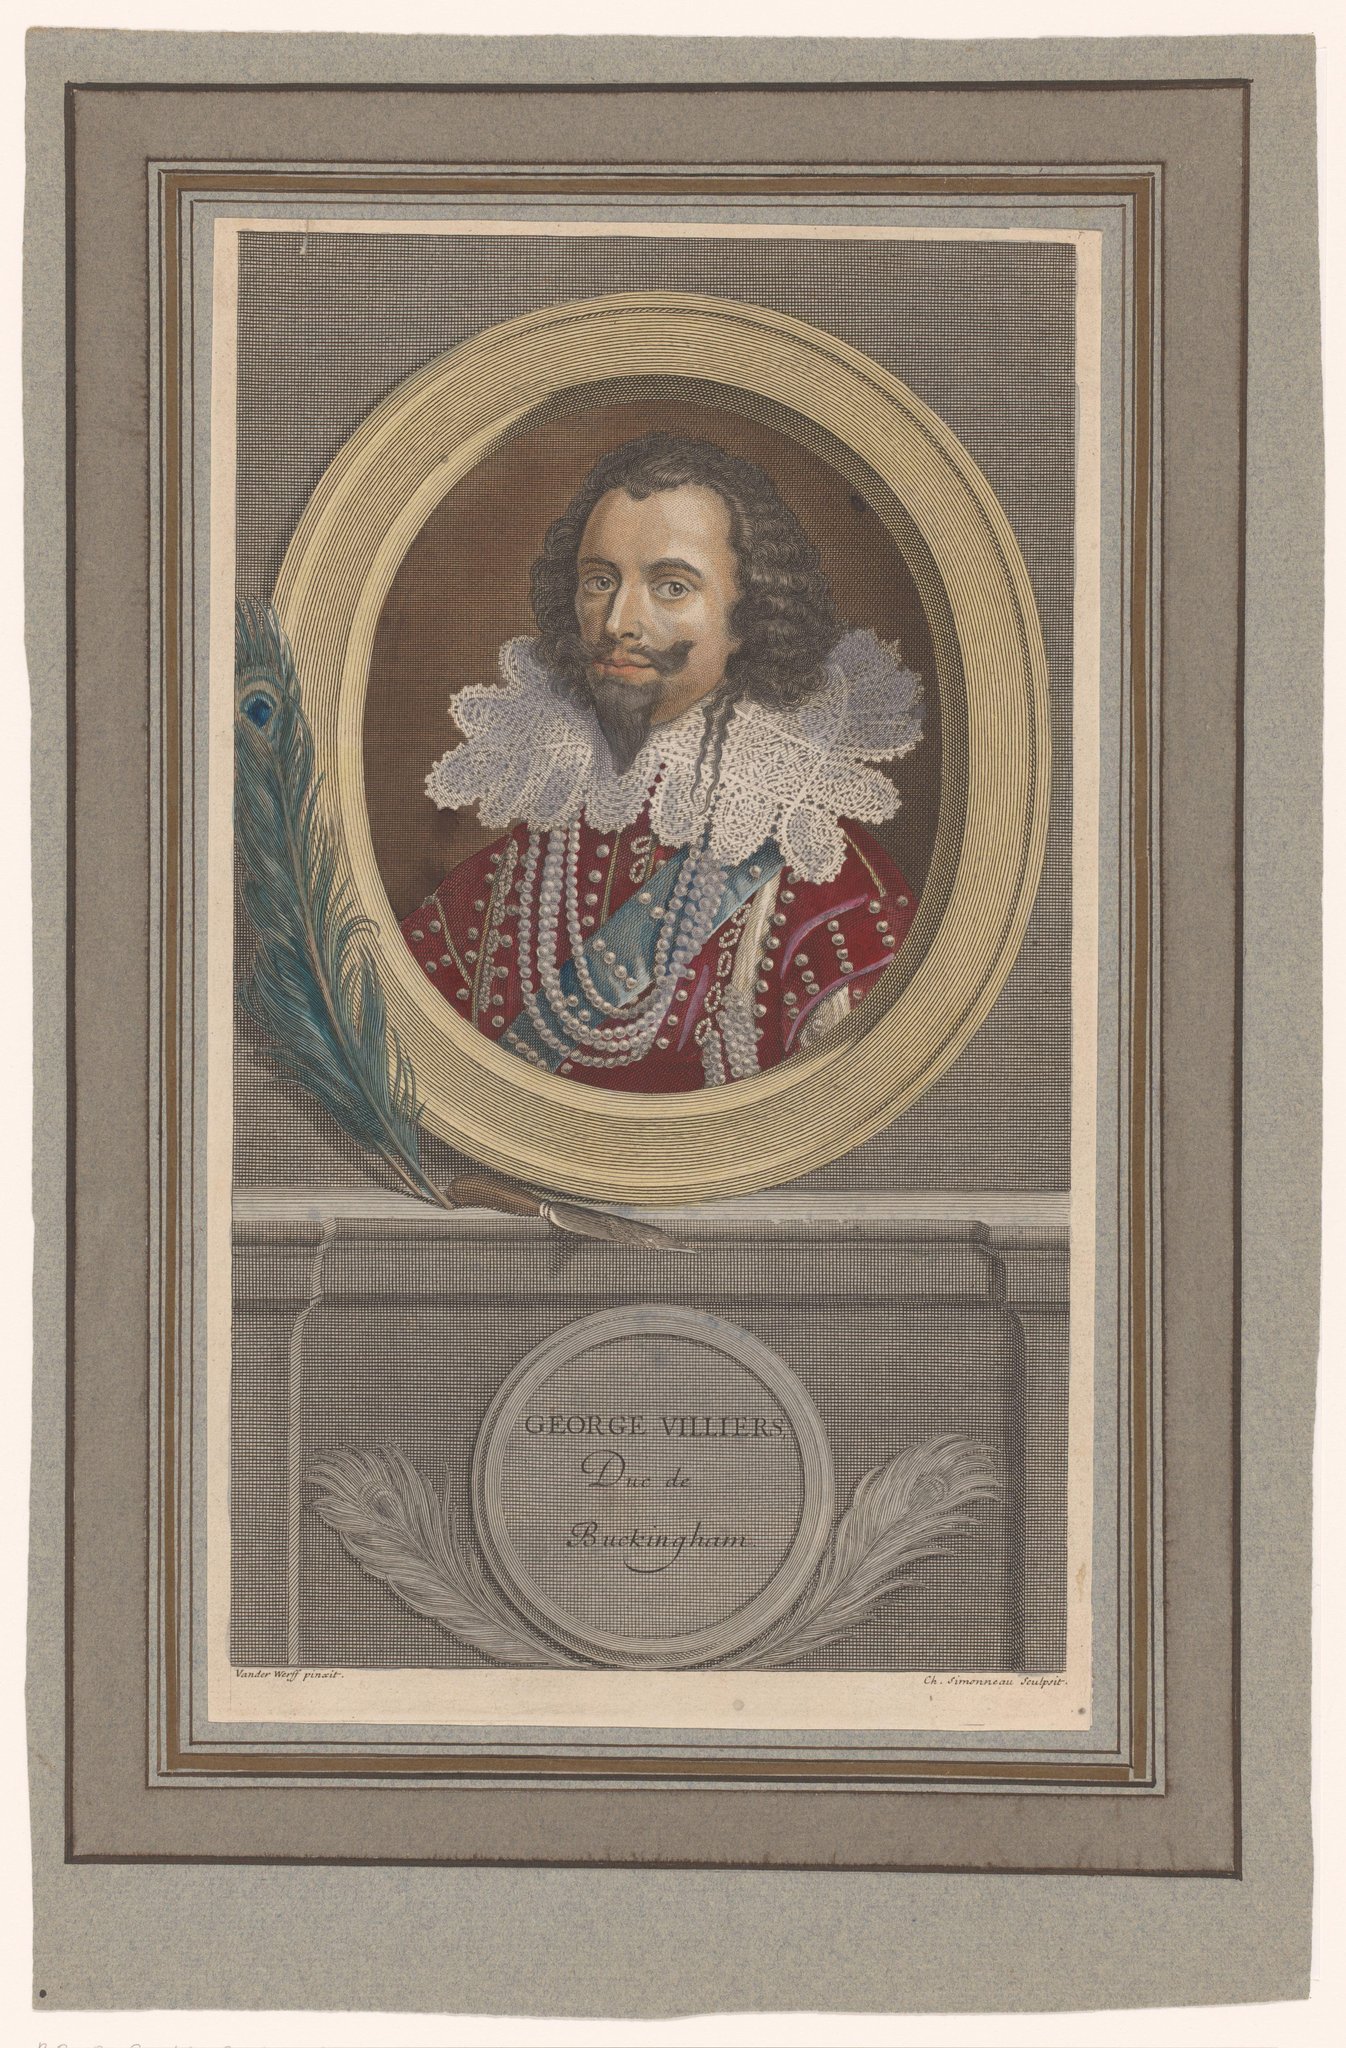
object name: print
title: Portraits of Robert Devereux, Earl of Essex, and George Villiers, Duke of Buckingham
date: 1655-1728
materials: paper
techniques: engraving, etching, hand coloring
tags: historical persons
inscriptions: collector's mark: Lugt 2228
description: These portraits come from a richly illustrated book on the history of England, Scotland, and Ireland published in Rotterdam around 1700. However, a presumably 18th-century owner cut them out of the book, pasted them onto mounts, and provided them with a grey border. The portraits were then also coloured in. Probably to hang them up as small paintings afterwards.